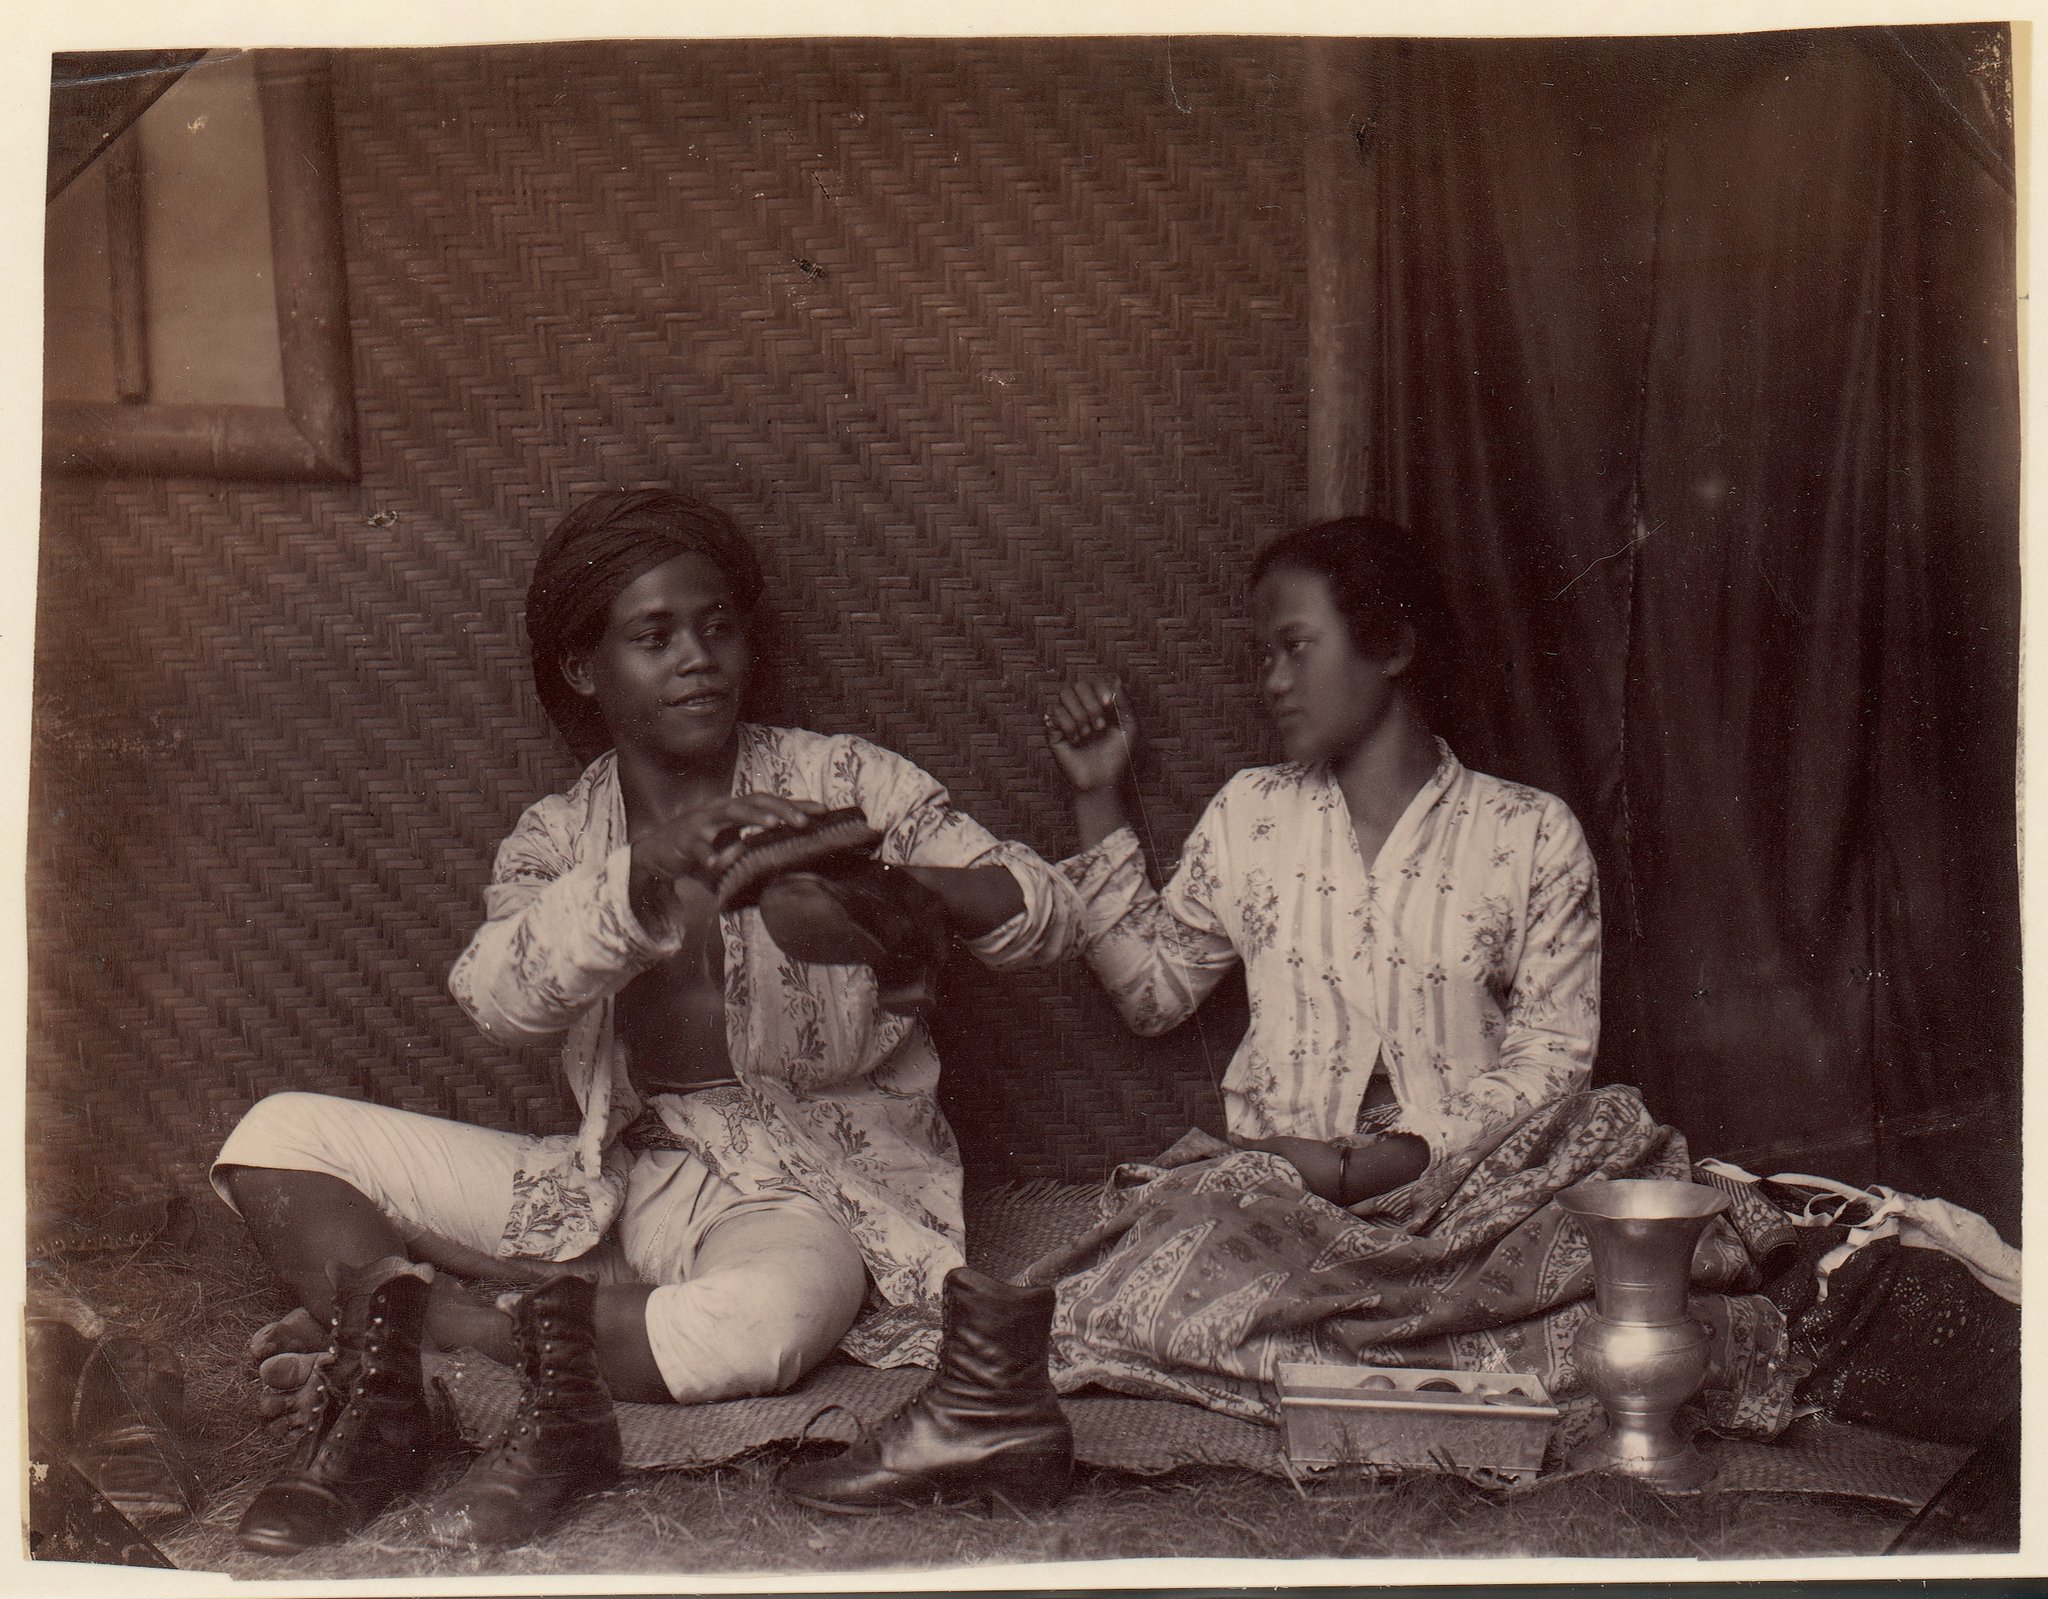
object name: photograph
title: Servants, Batavia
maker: Anonymous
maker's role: artist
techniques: albumen silver print, glass negative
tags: human figures,servants